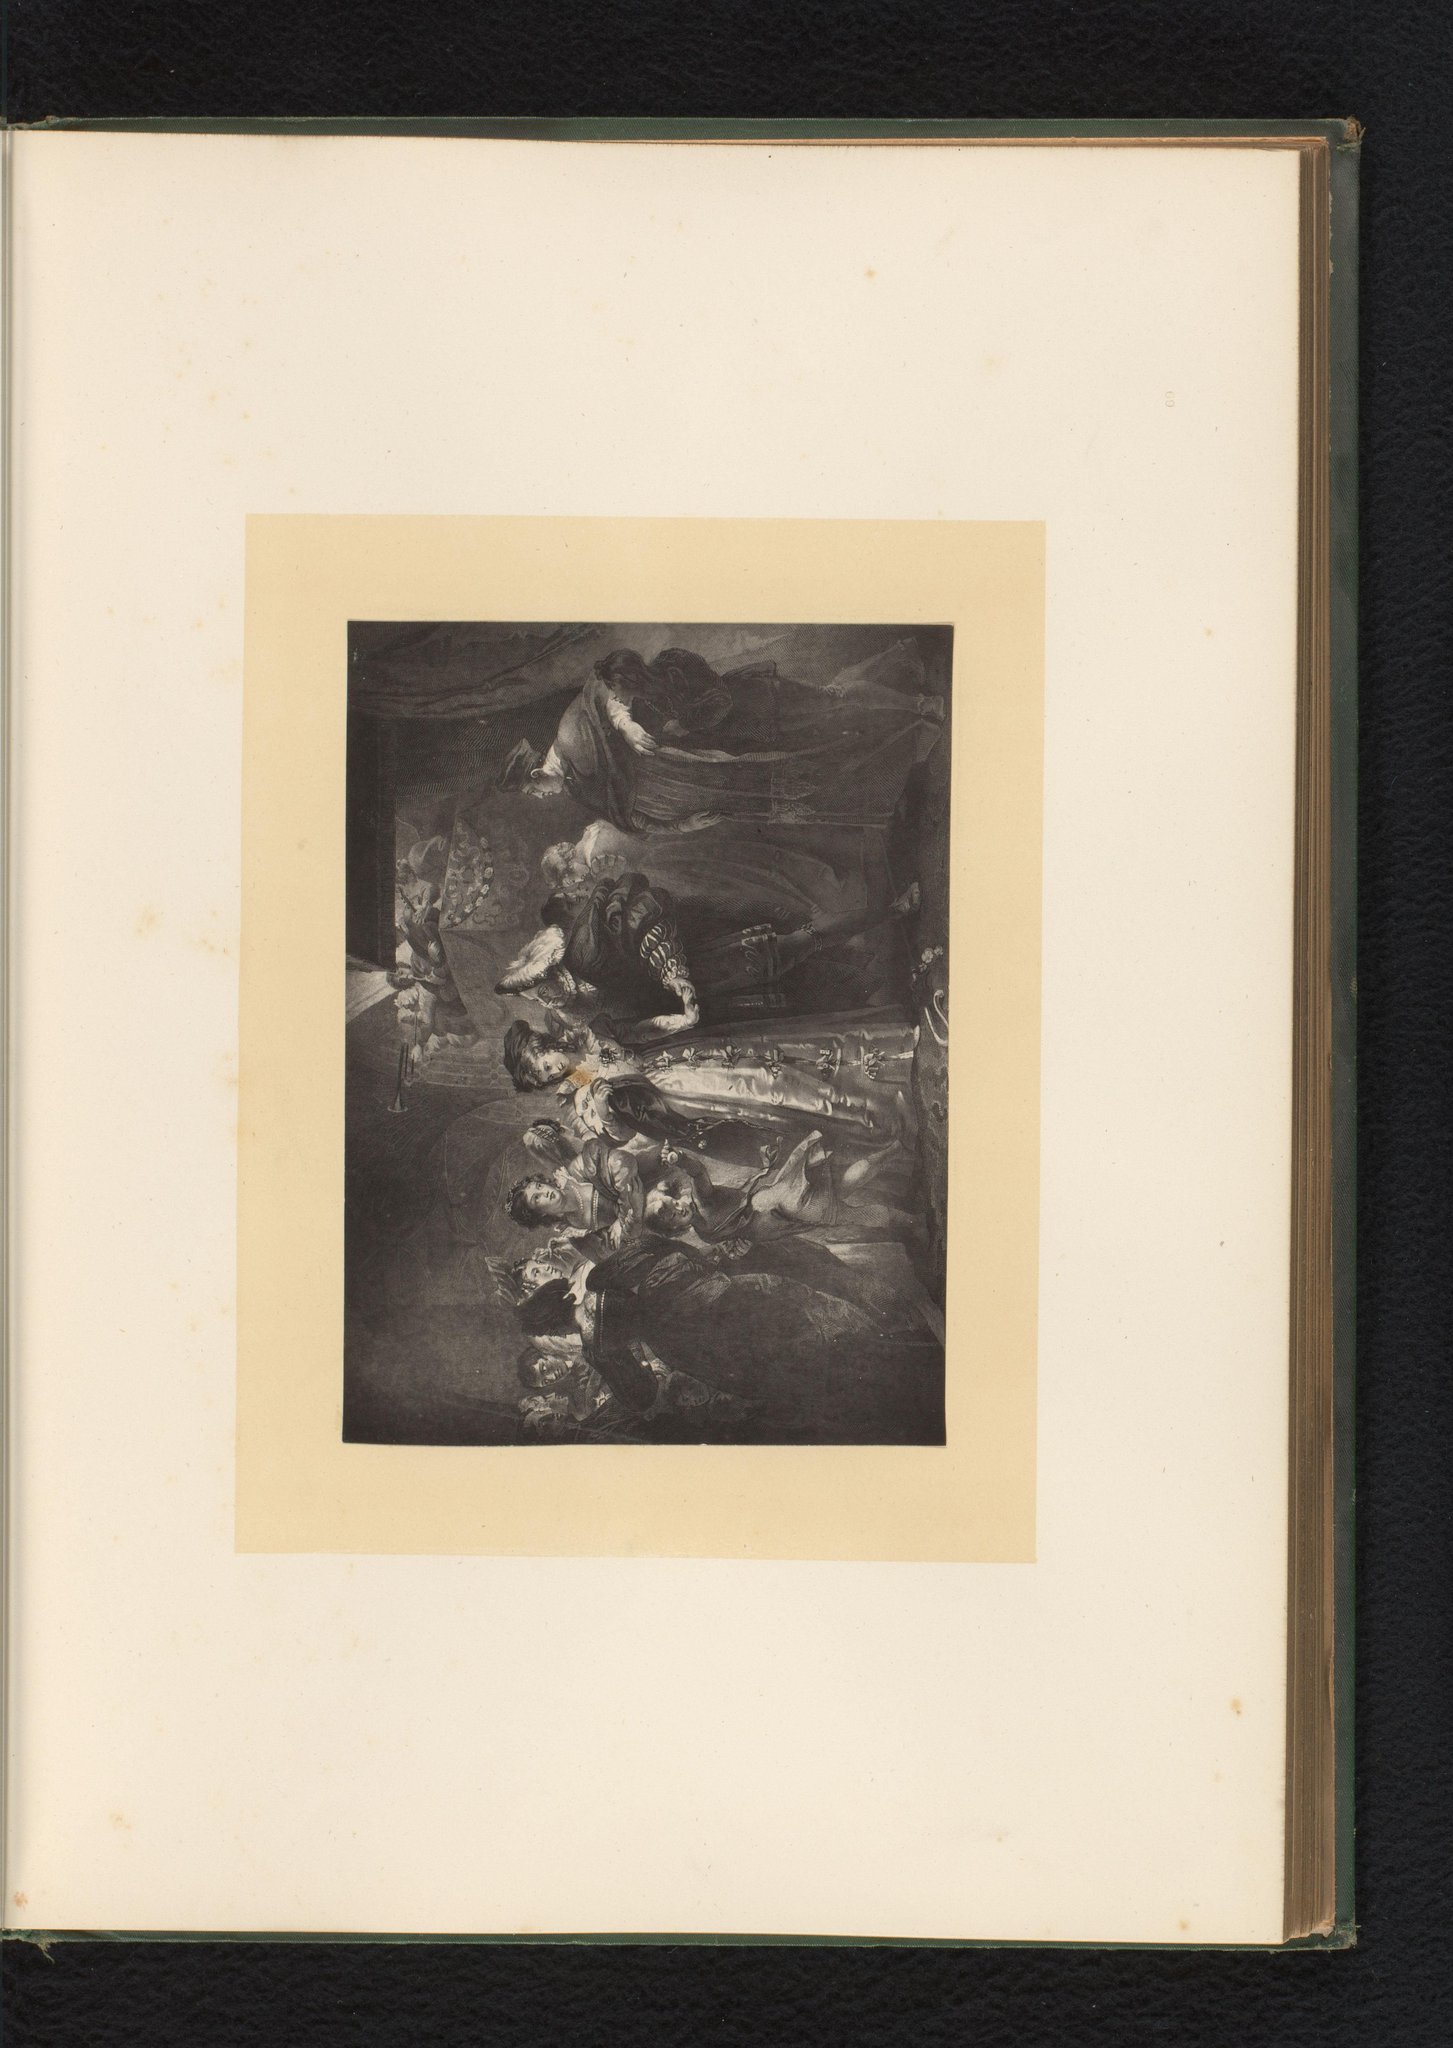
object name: page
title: King Henry the Eighth, Act I, Scene 4: York Place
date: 1874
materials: paper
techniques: woodburytype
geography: london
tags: 83(shakespeare, henry viii)